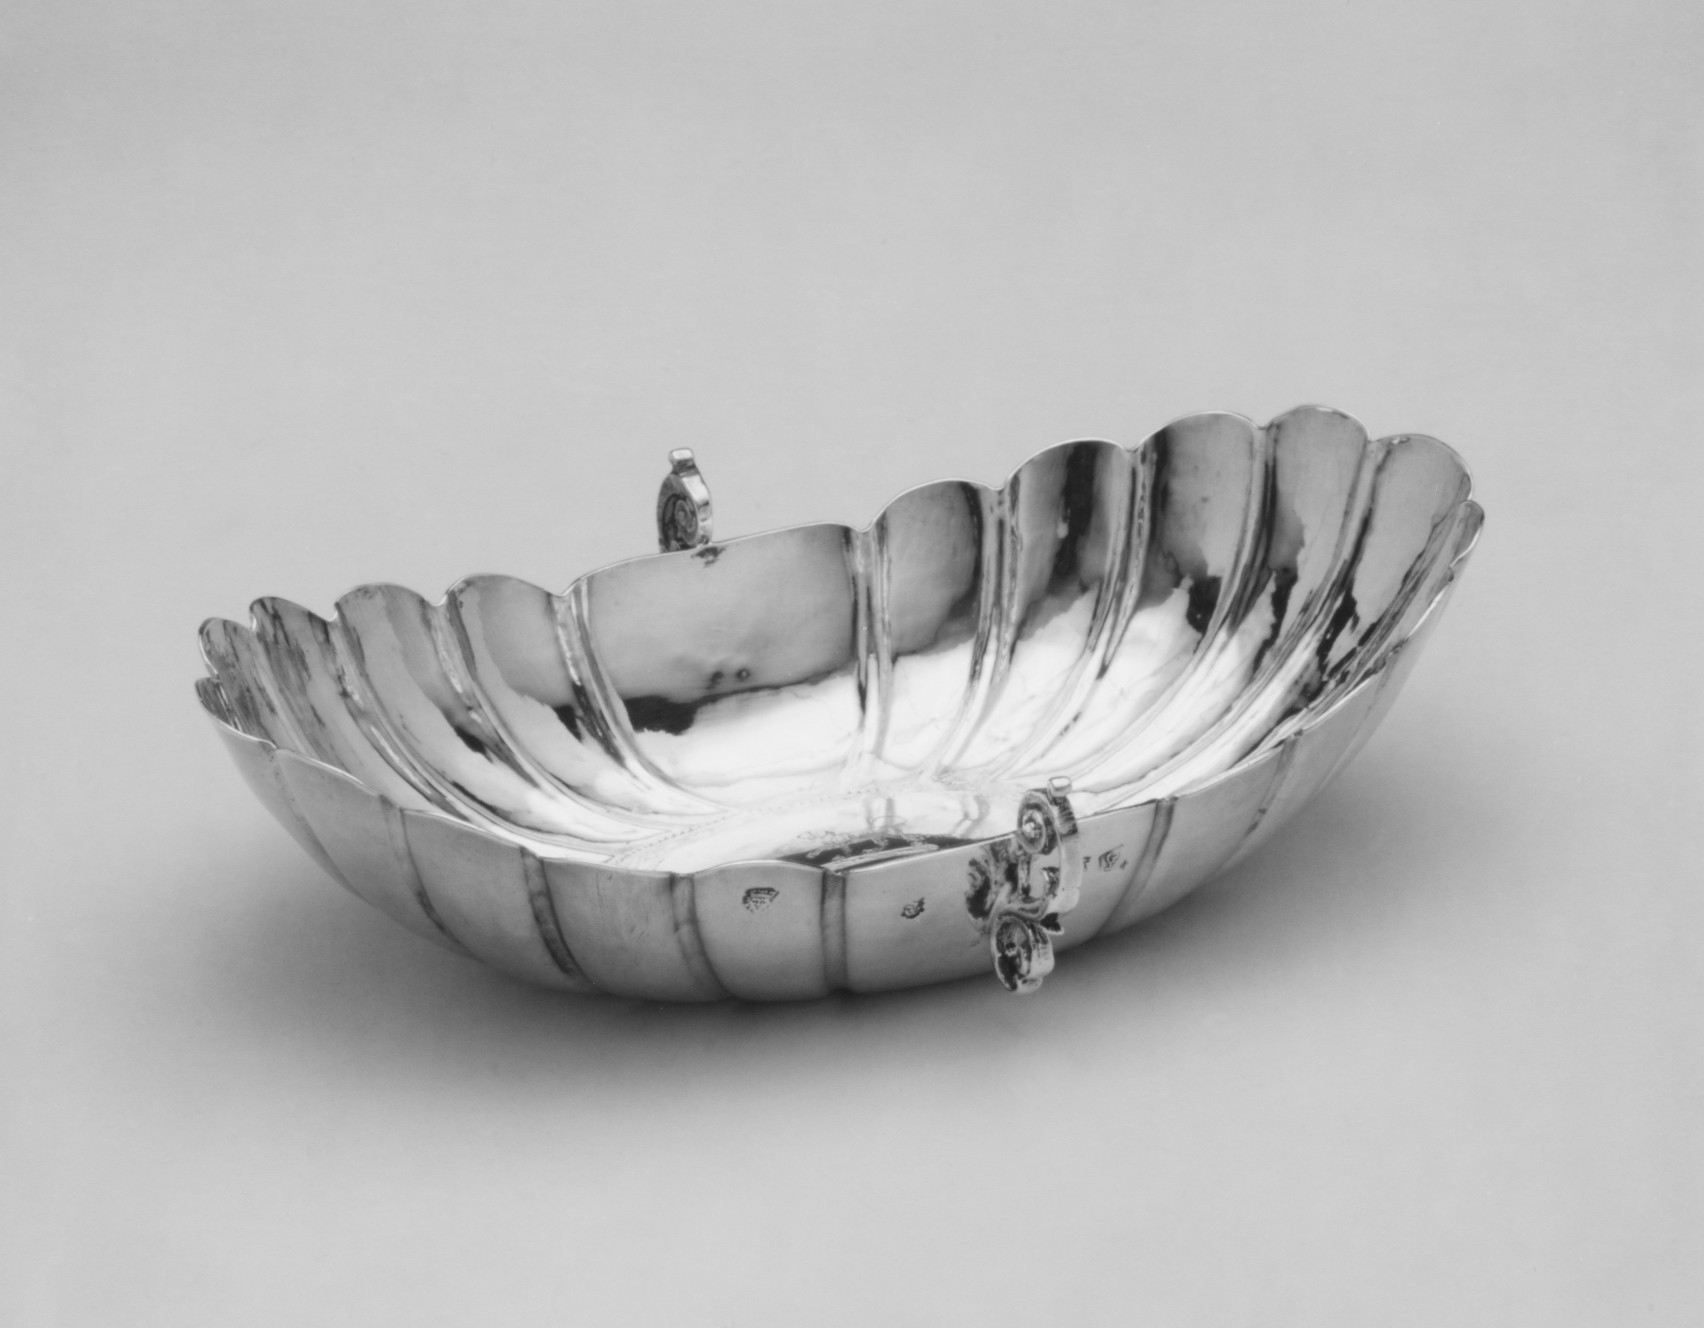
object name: sweetmeat dish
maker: s. w., london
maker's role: maker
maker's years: 1625-1637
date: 1627-1628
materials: silver